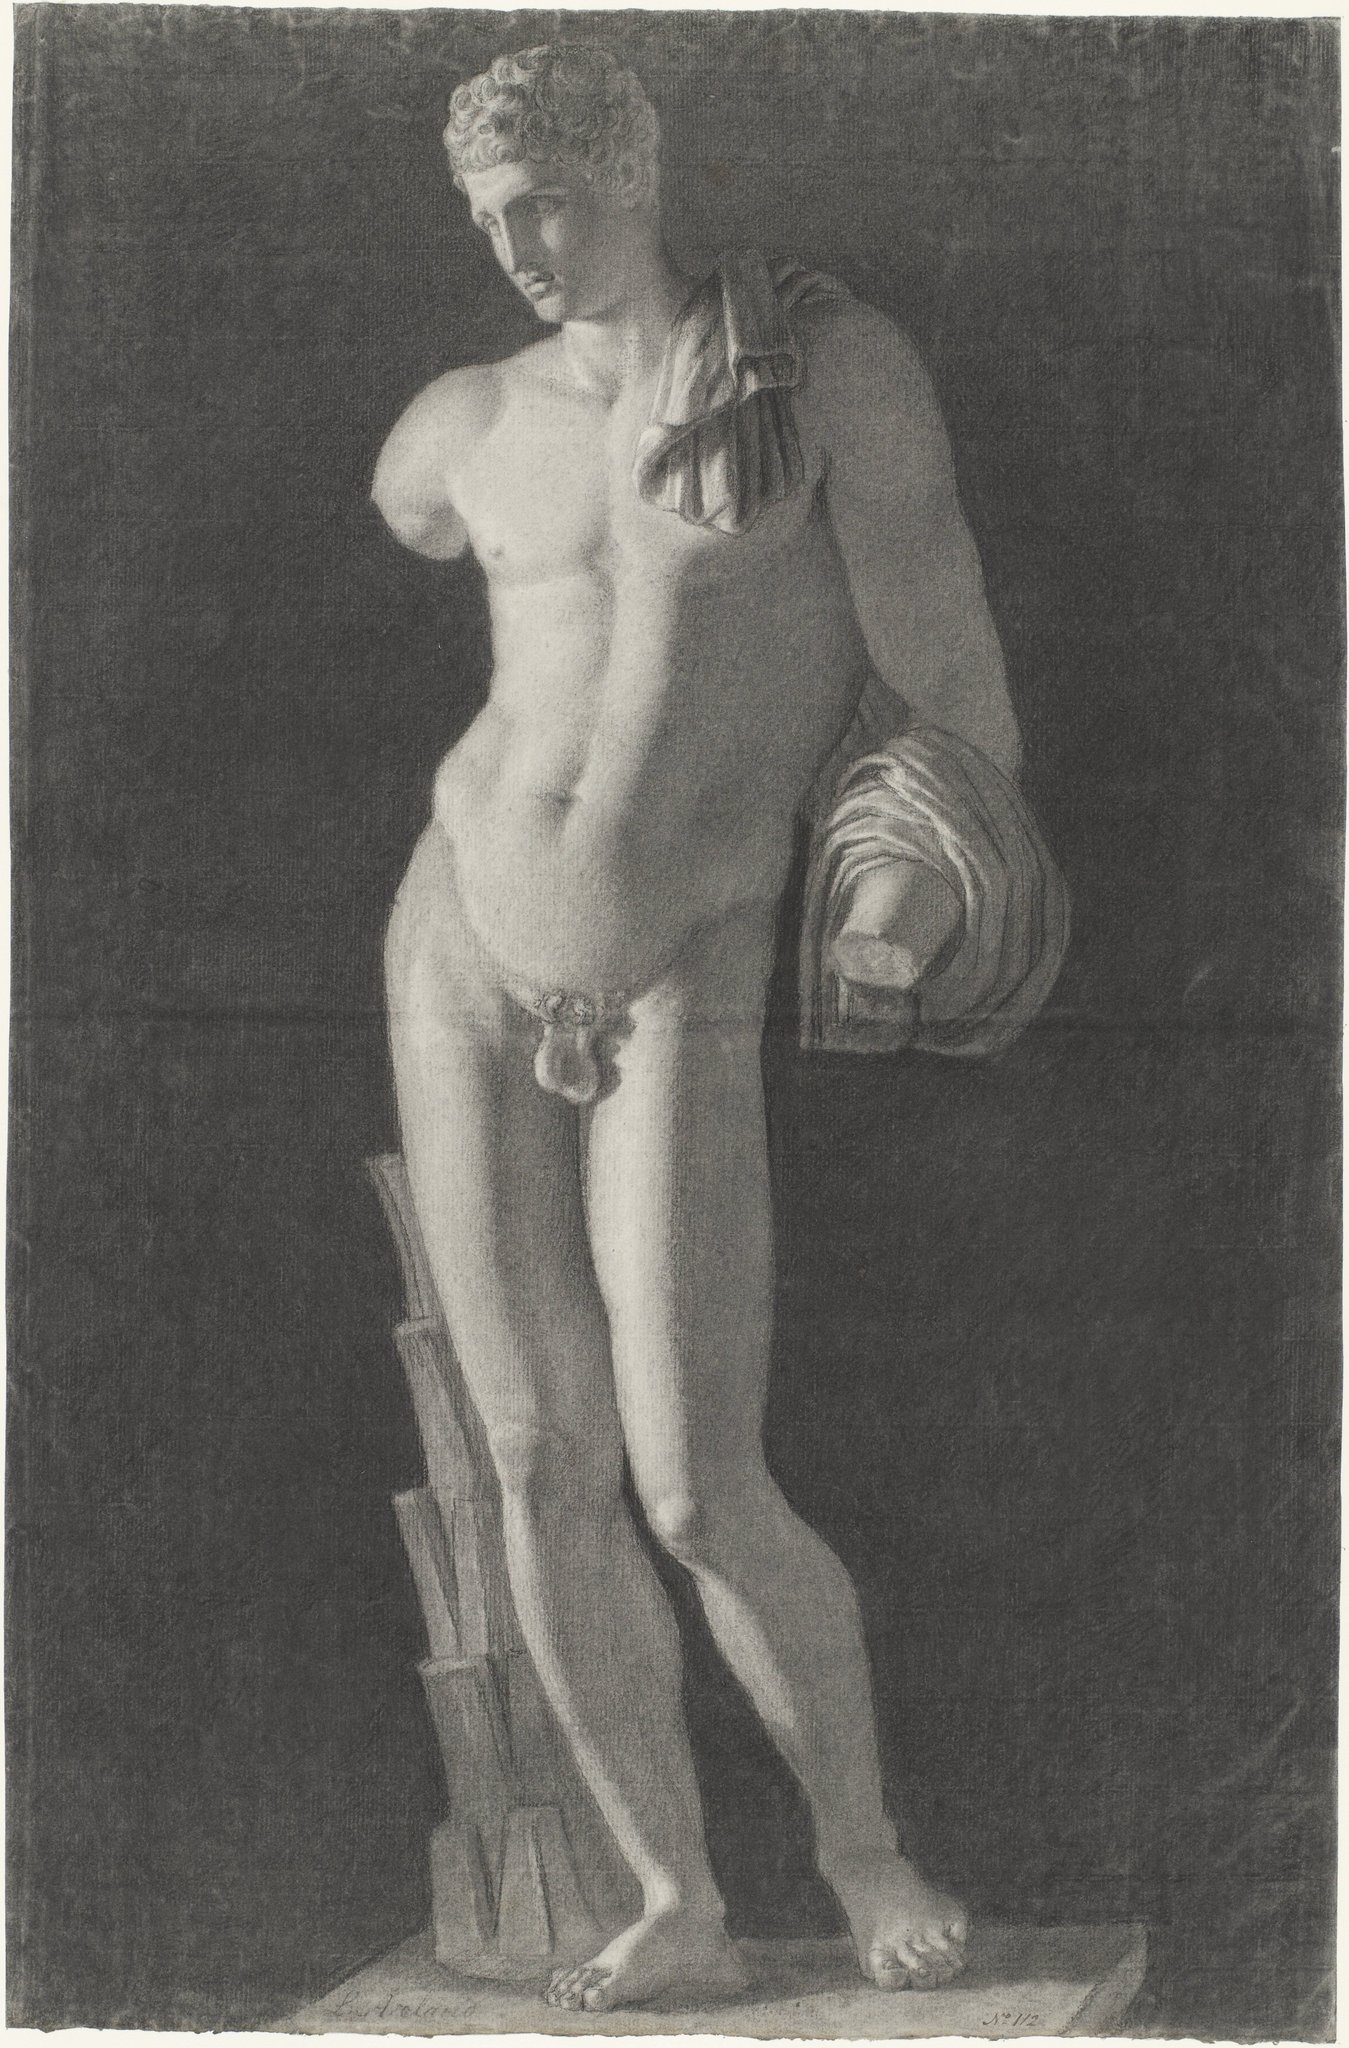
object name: drawing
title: De Apollo Belvedere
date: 1700-1850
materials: chalk, paper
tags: piece of sculpture, reproduction of a piece of sculpture